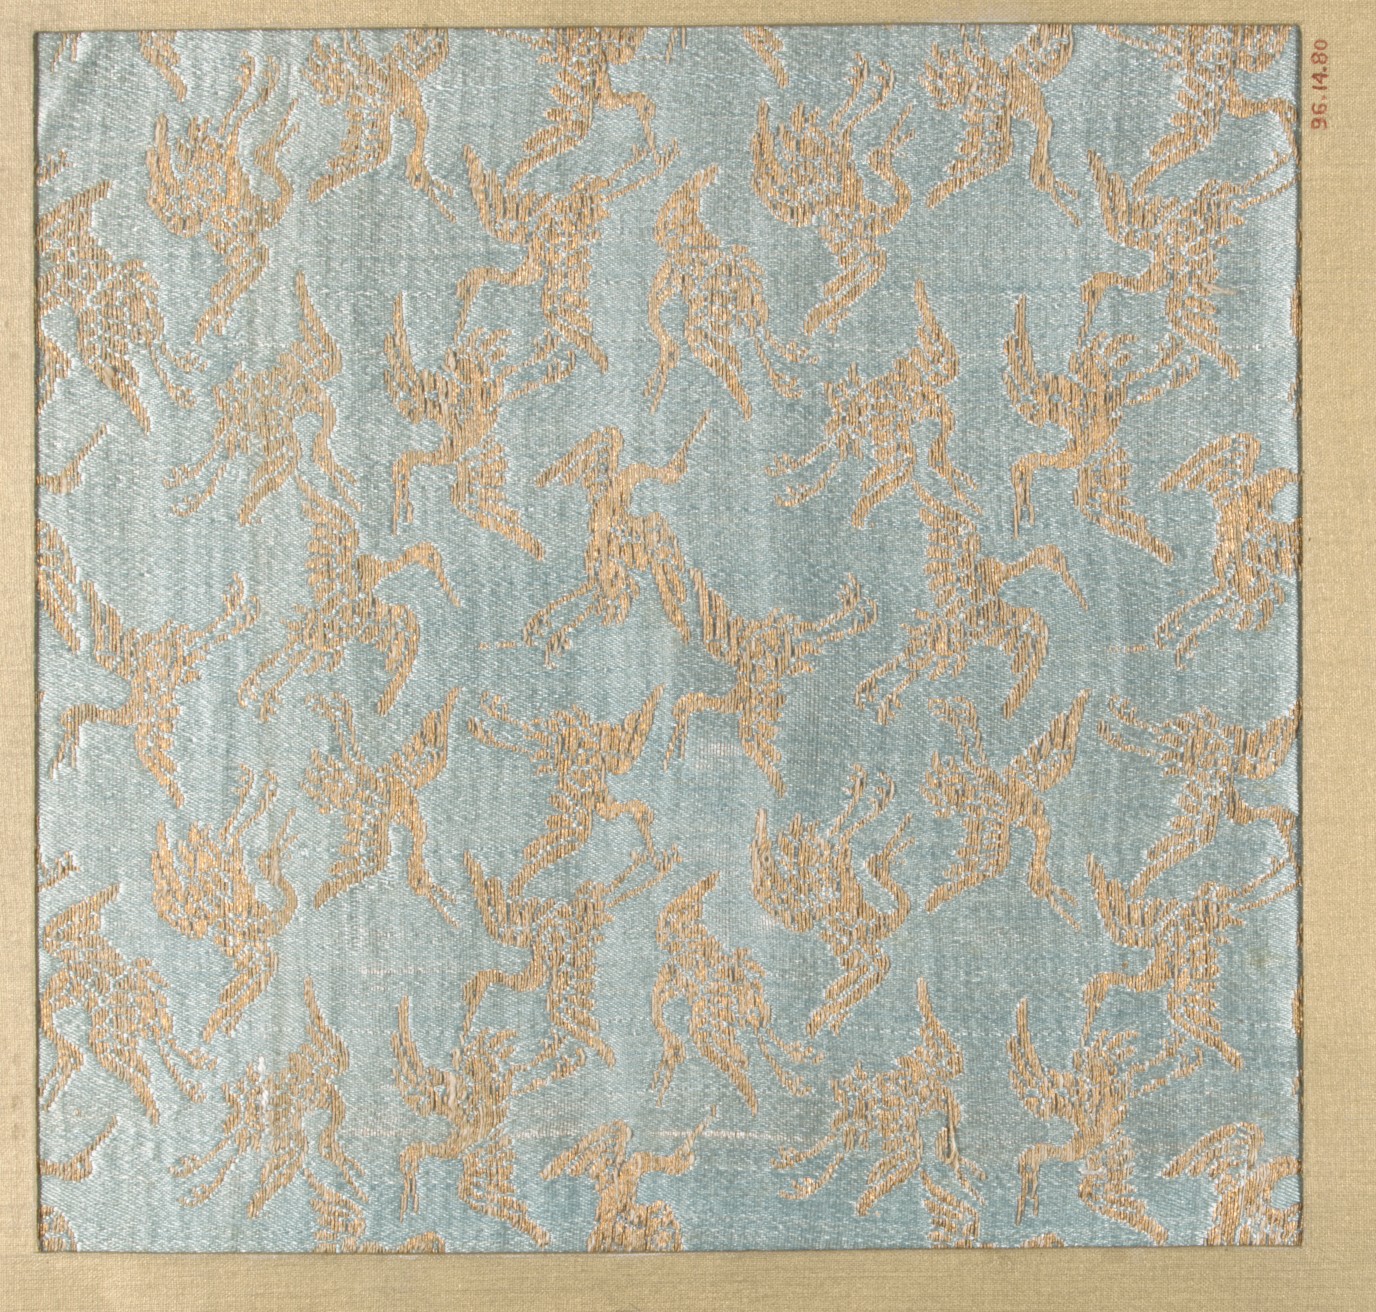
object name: piece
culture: japanese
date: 1701-1900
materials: silk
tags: cranes